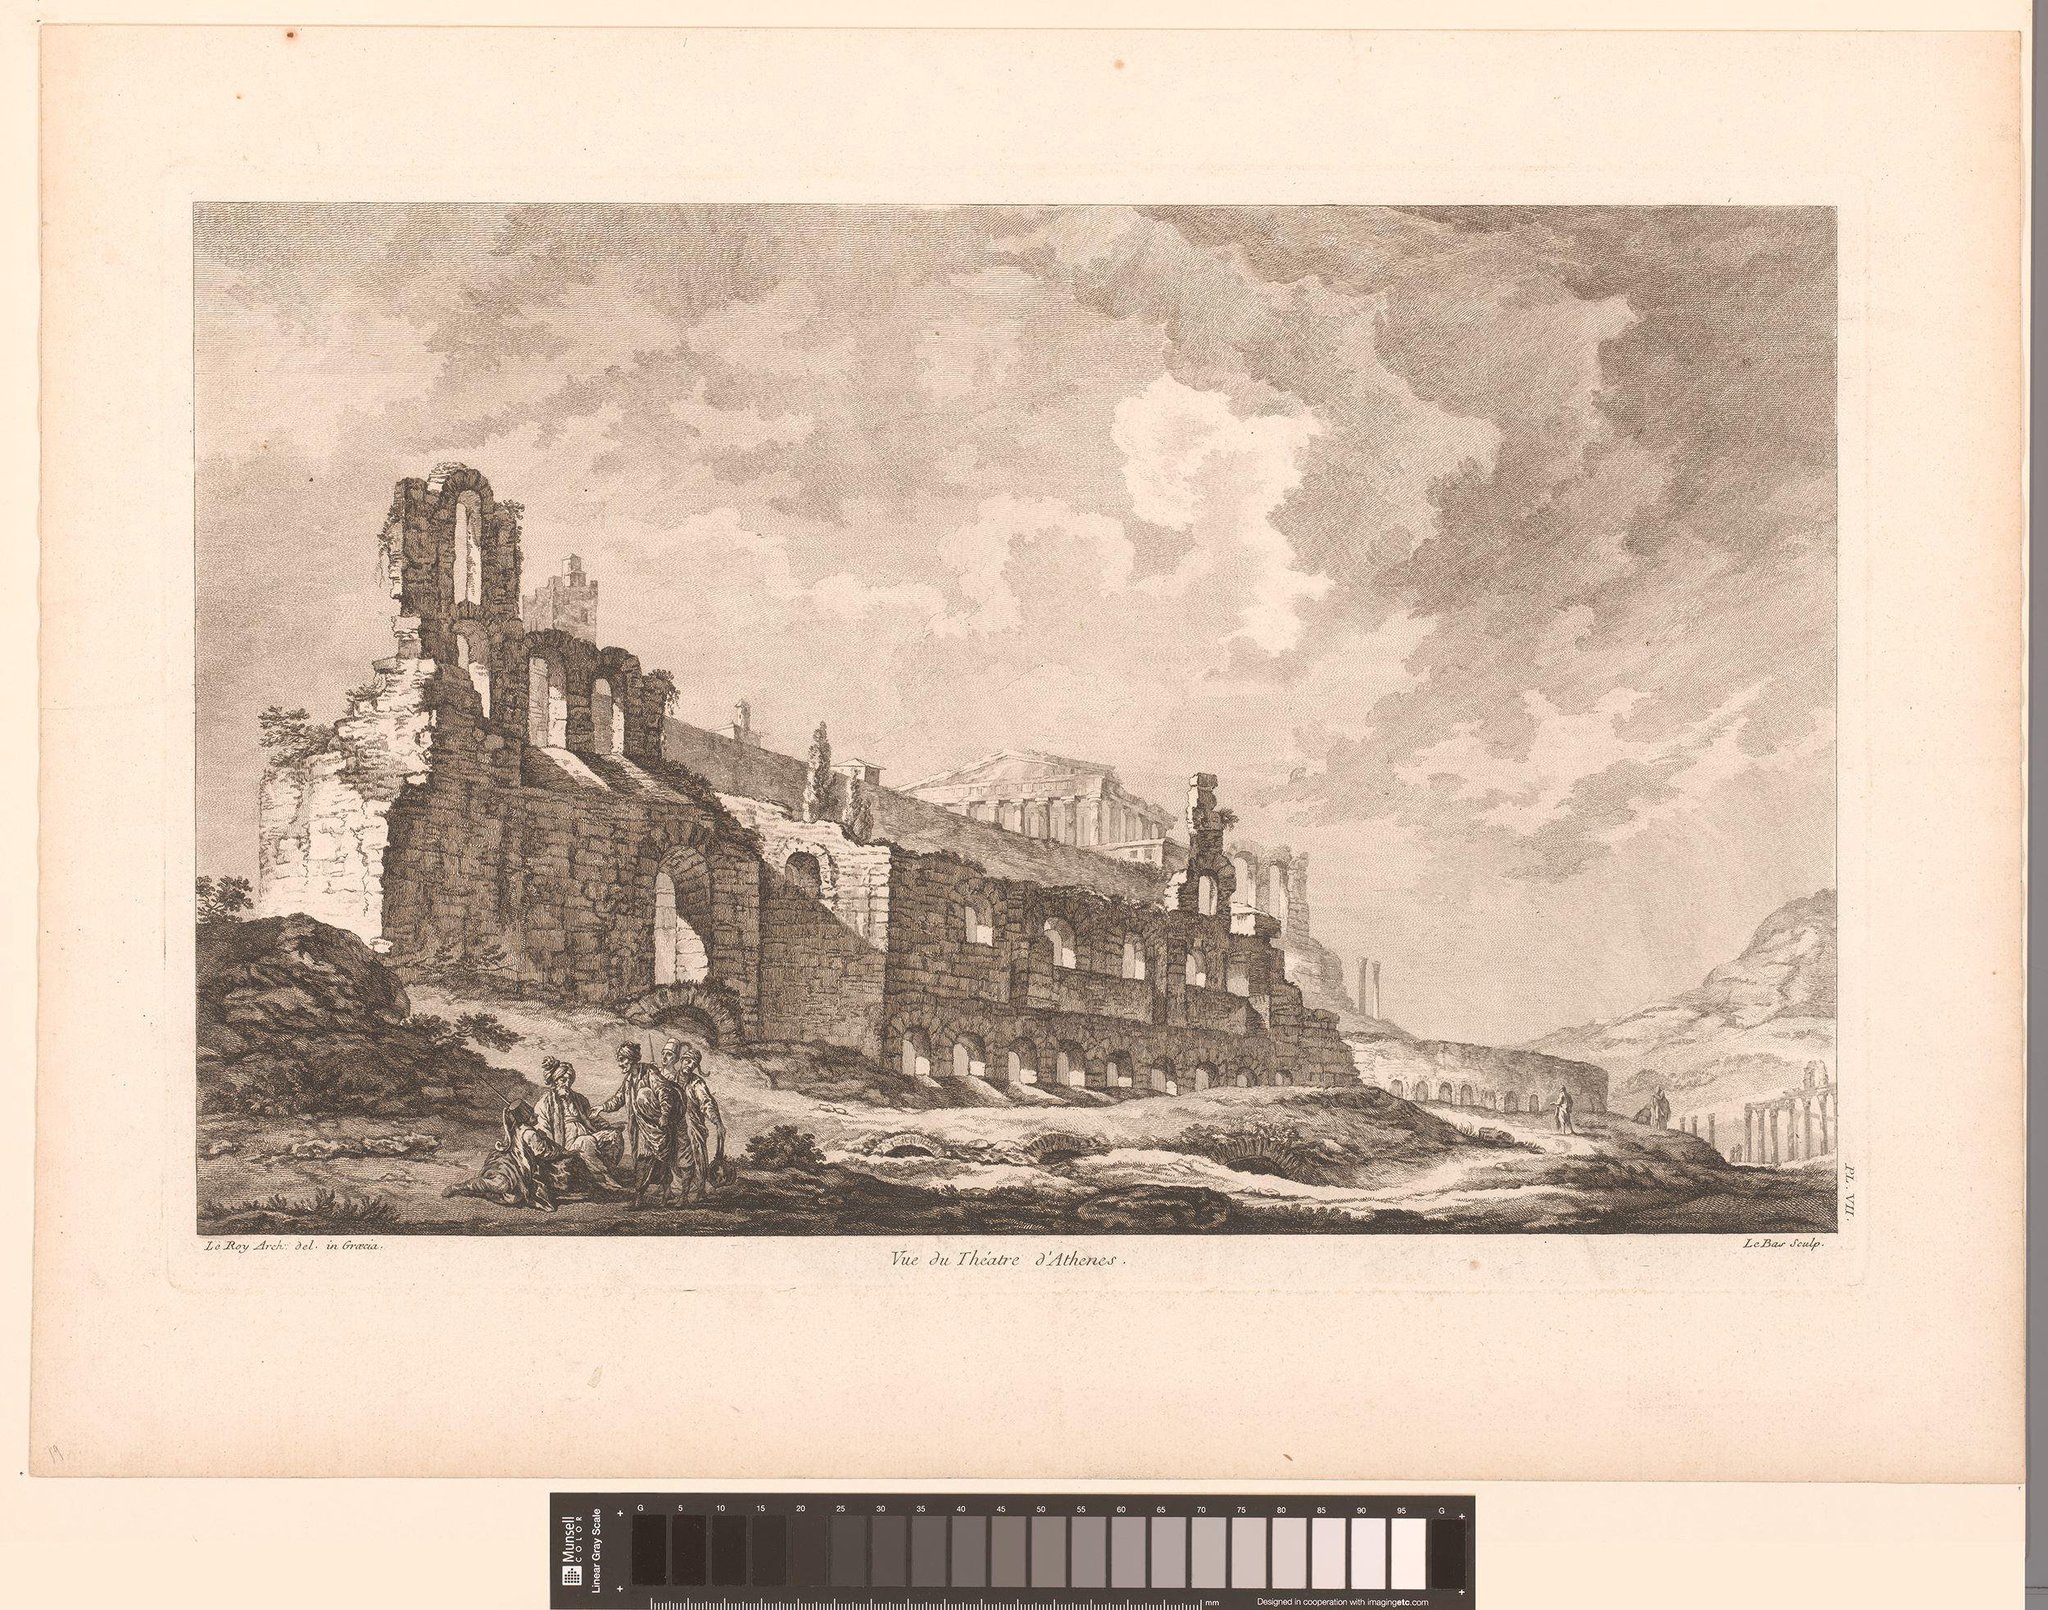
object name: print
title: Gezicht op het Odeion van Herodes Atticus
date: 1758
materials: paper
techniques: etching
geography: greece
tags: ruin of a building ~ architecture, landscape with ruins, theatre (building)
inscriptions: collector's mark: Lugt 2760, collector's mark: Lugt 2228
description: Prent uit: Le Roy, Julien. Ruines des plus beaux monuments de la Grêce. Parijs: Guérin & de La Tour, 1758. Dit betreft plaat VII.